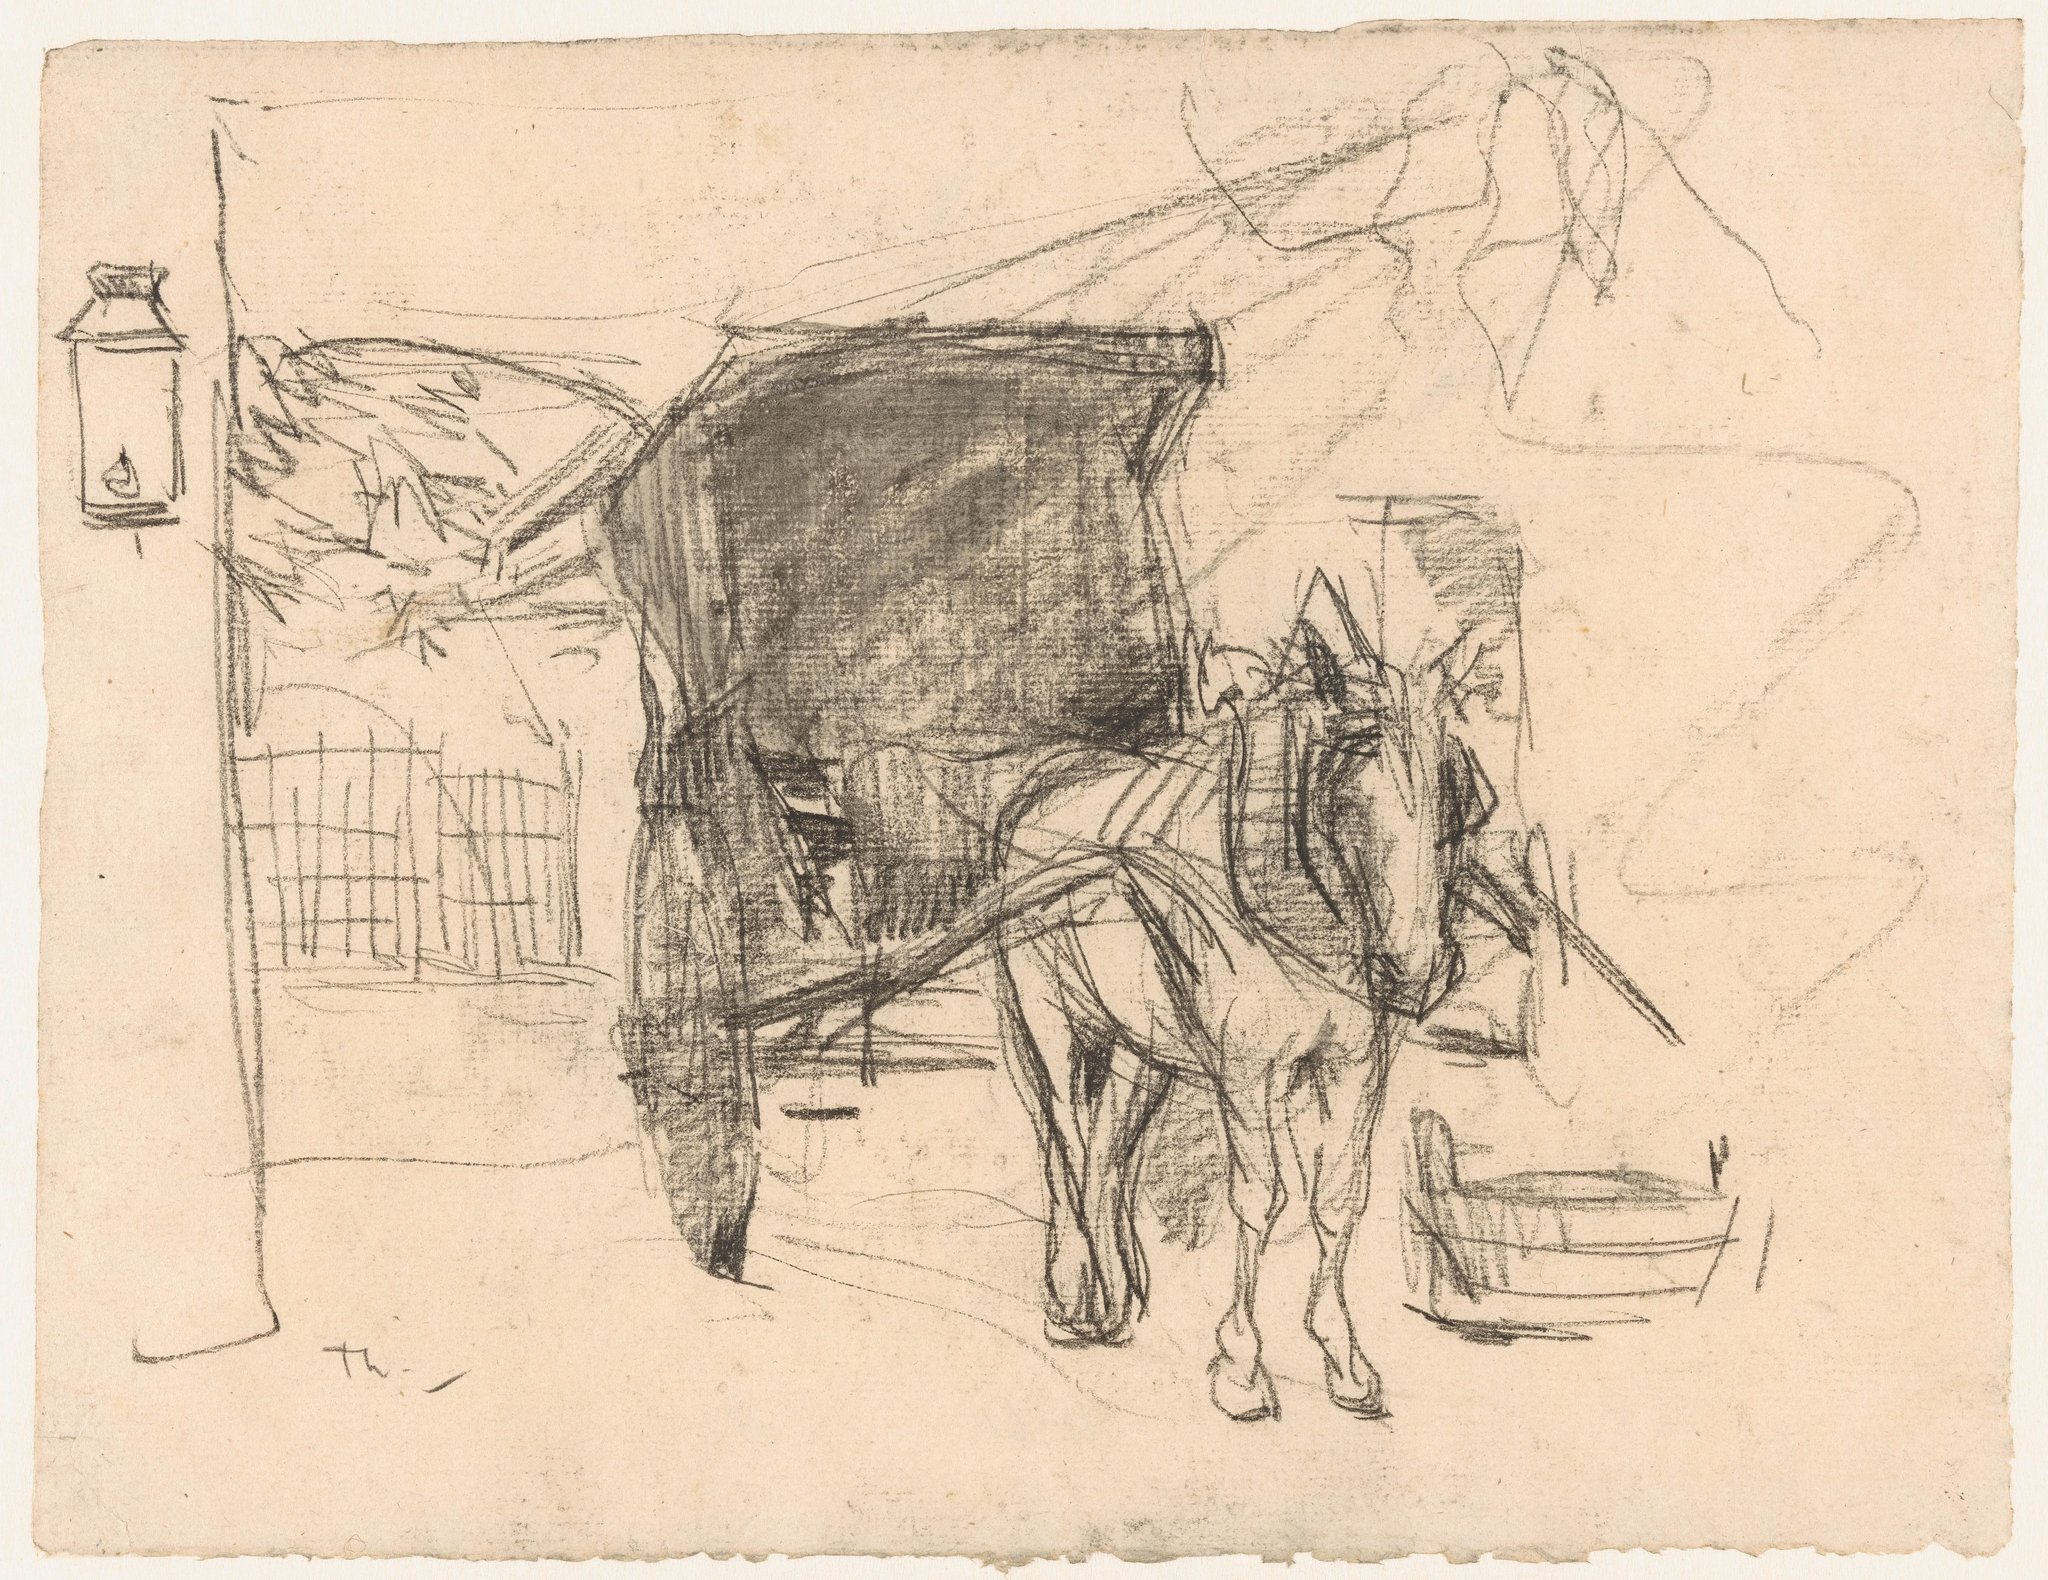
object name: drawing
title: Paard en wagen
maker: willem bastiaan tholen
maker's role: draughtsman, painter, print maker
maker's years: 1860-1931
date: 1870-1931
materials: chalk, paper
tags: horse, two-wheeled vehicle drawn by one animal